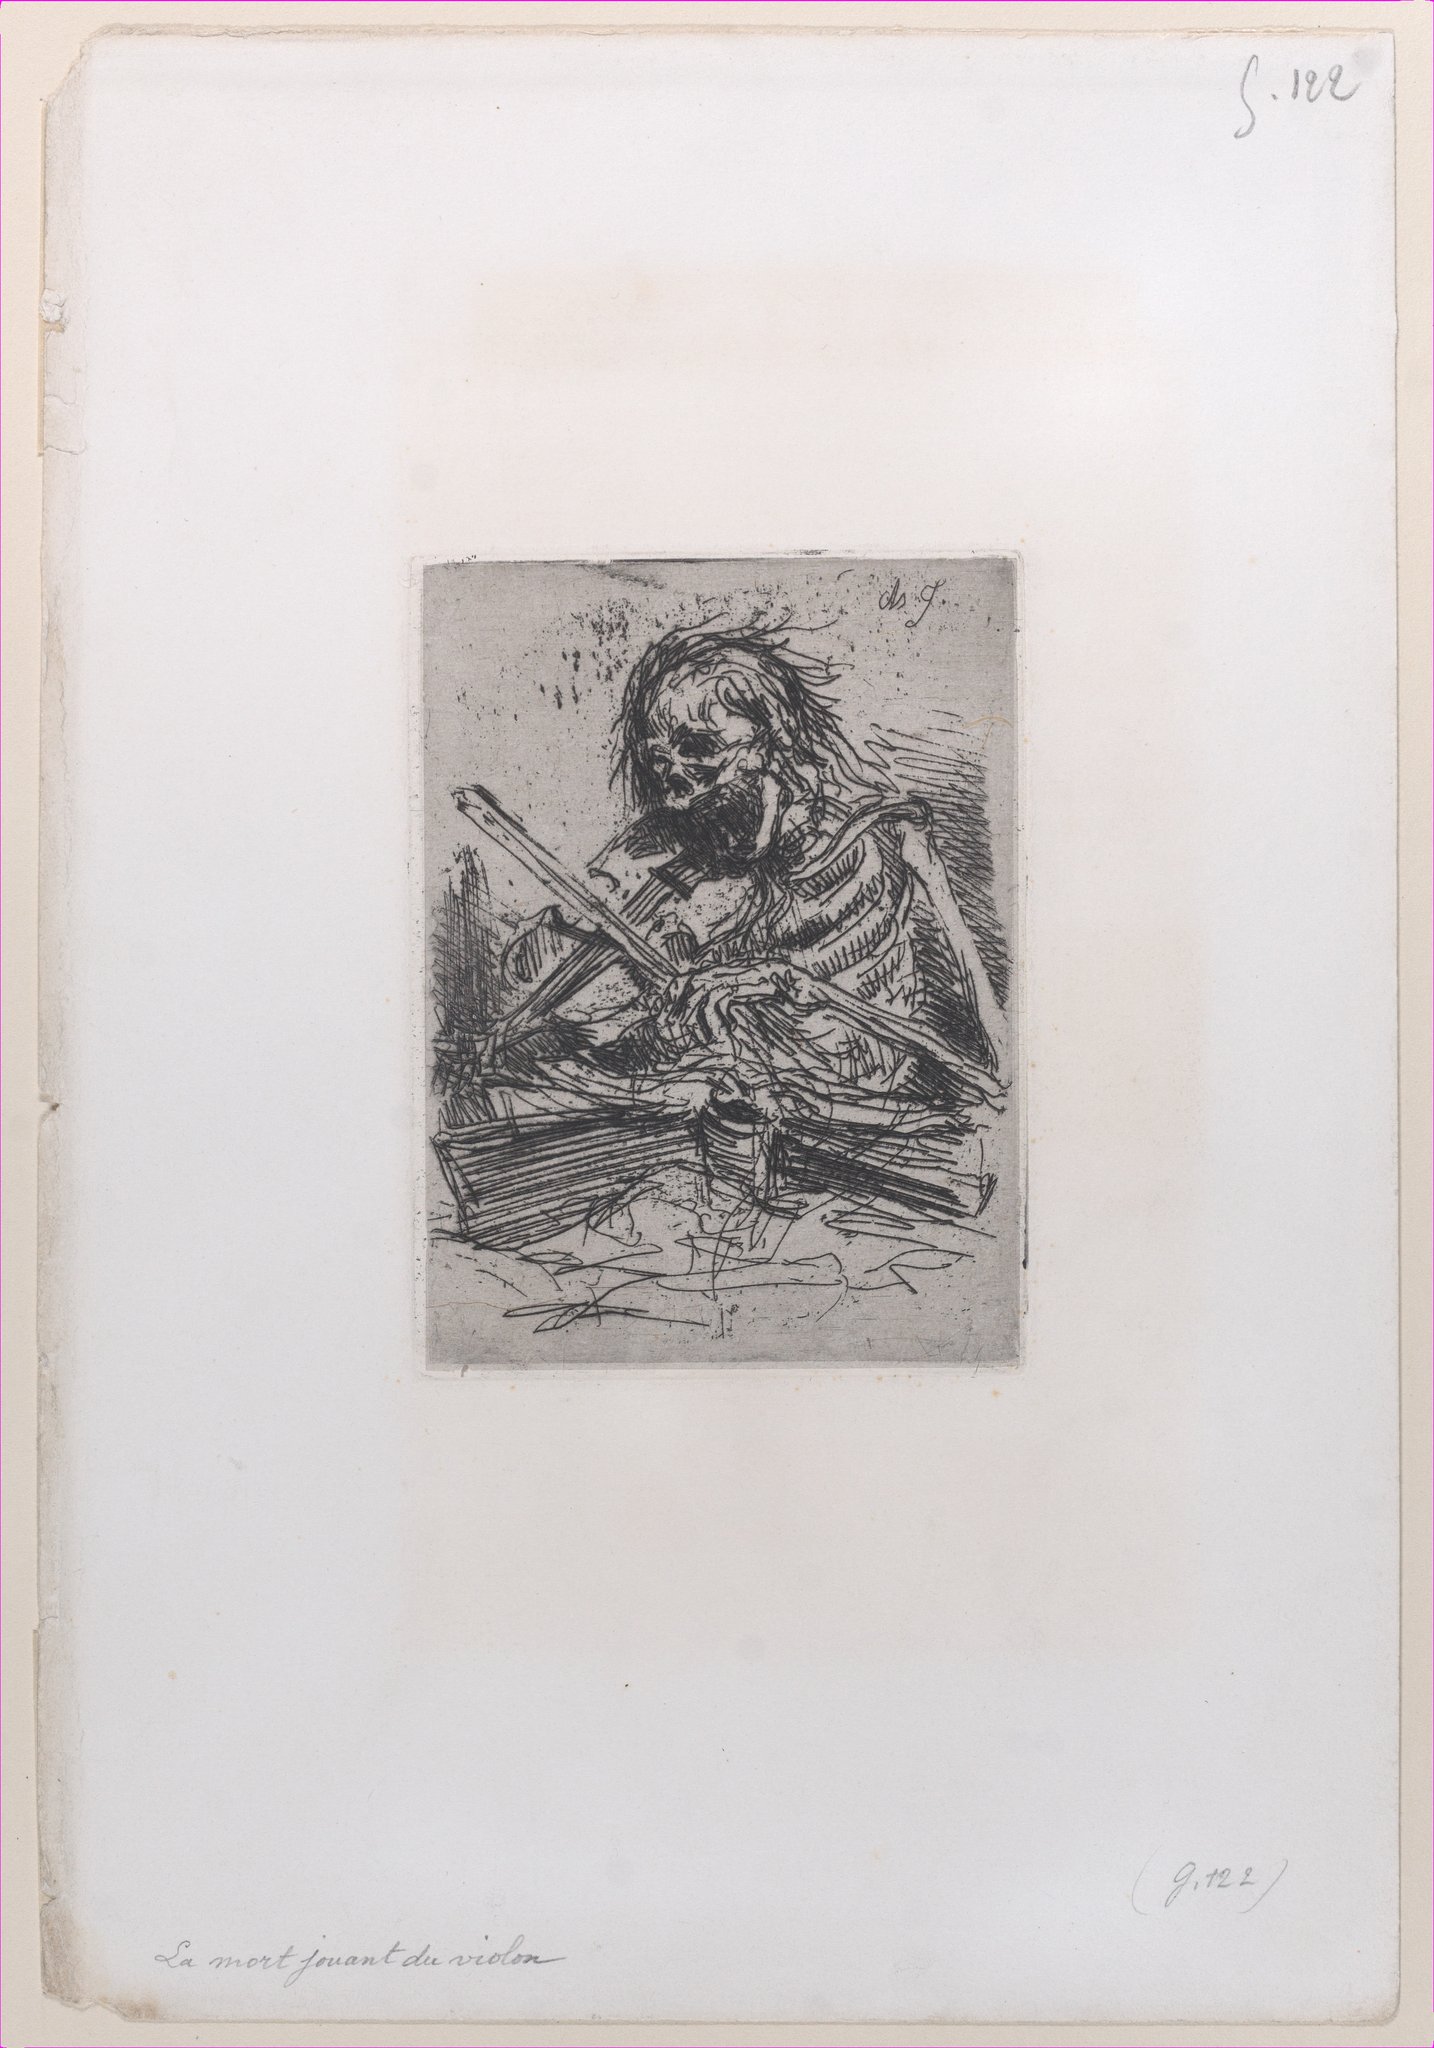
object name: print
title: Death Playing the Violin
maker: charles émile jacque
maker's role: artist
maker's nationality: french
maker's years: 1813-1894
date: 1846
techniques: etching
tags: skeletons,violins